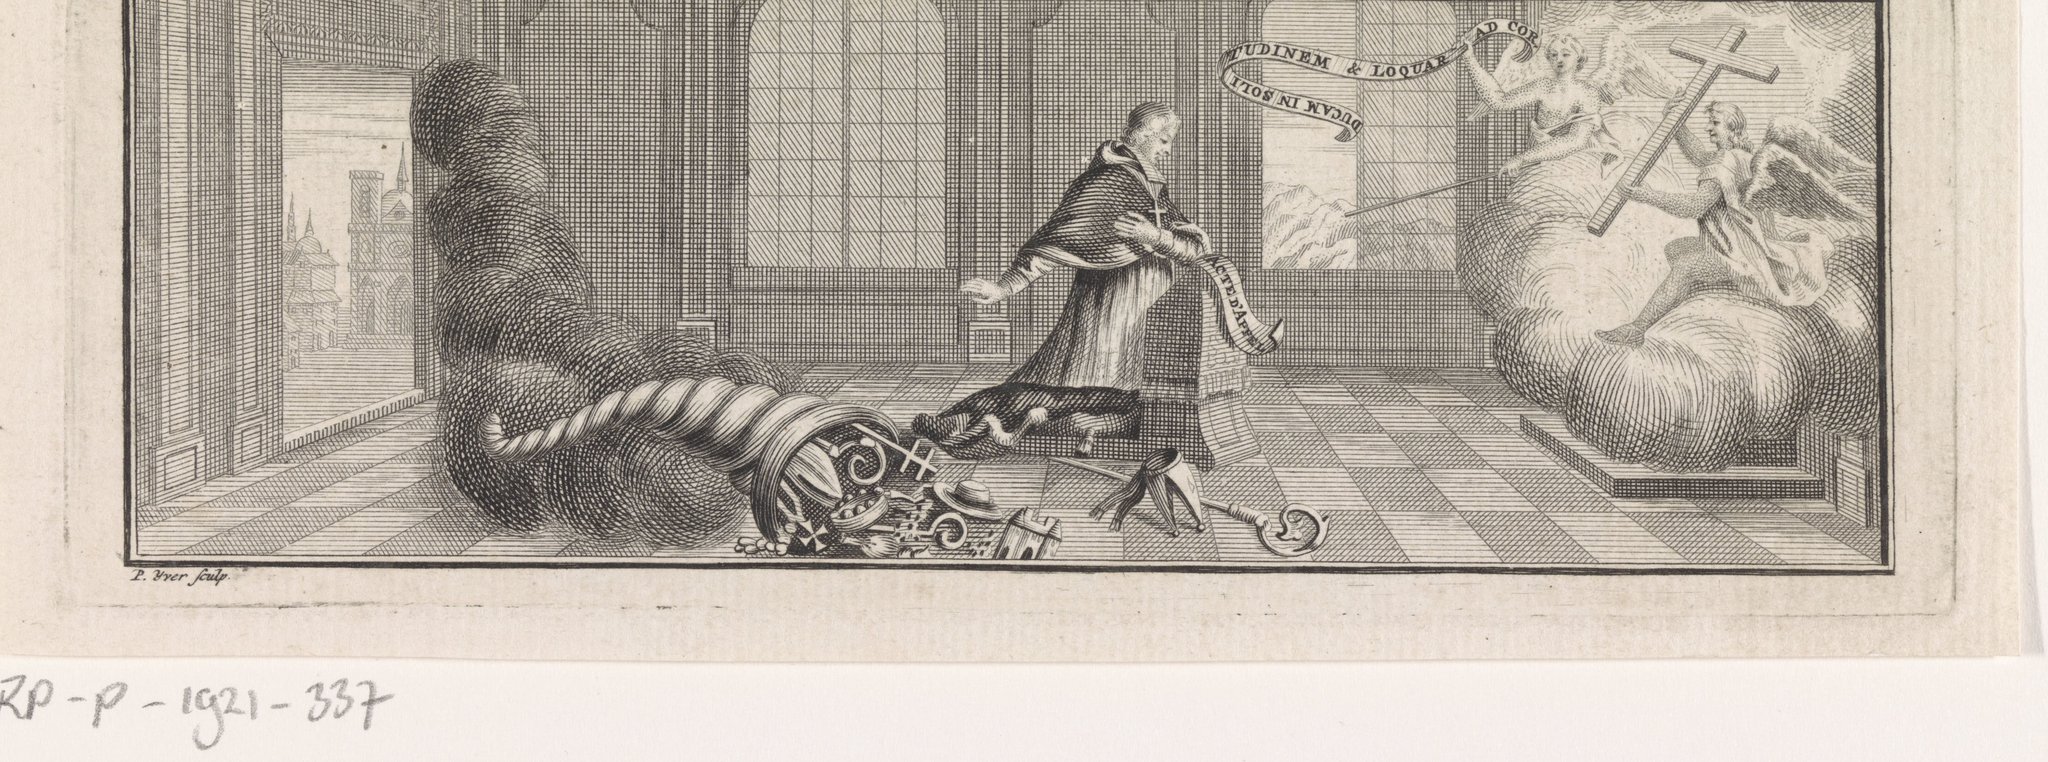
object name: print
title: Knielende geestelijke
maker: pieter yver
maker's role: print maker, publisher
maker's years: 1712-1787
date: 1722-1787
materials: paper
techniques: engraving, etching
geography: amsterdam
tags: 'cornucopia', horn of plenty (+ variant), the cross ~ symbols of christ, organization, functionaries and dignitaries in roman catholic church; clergy in general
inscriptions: collector's mark: Lugt 2233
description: Een geestelijke knielt en bidt, terwijl voor hem een engel met een banderol verschijnt. Op de banderol staat een tekst in het Latijn, die oproept om te denken volgens de taal van het hart. Een andere engel toont het kruis van Christus. Naast de geestelijke ligt een hoorn des overvloeds met symbolen van kerkelijke macht.